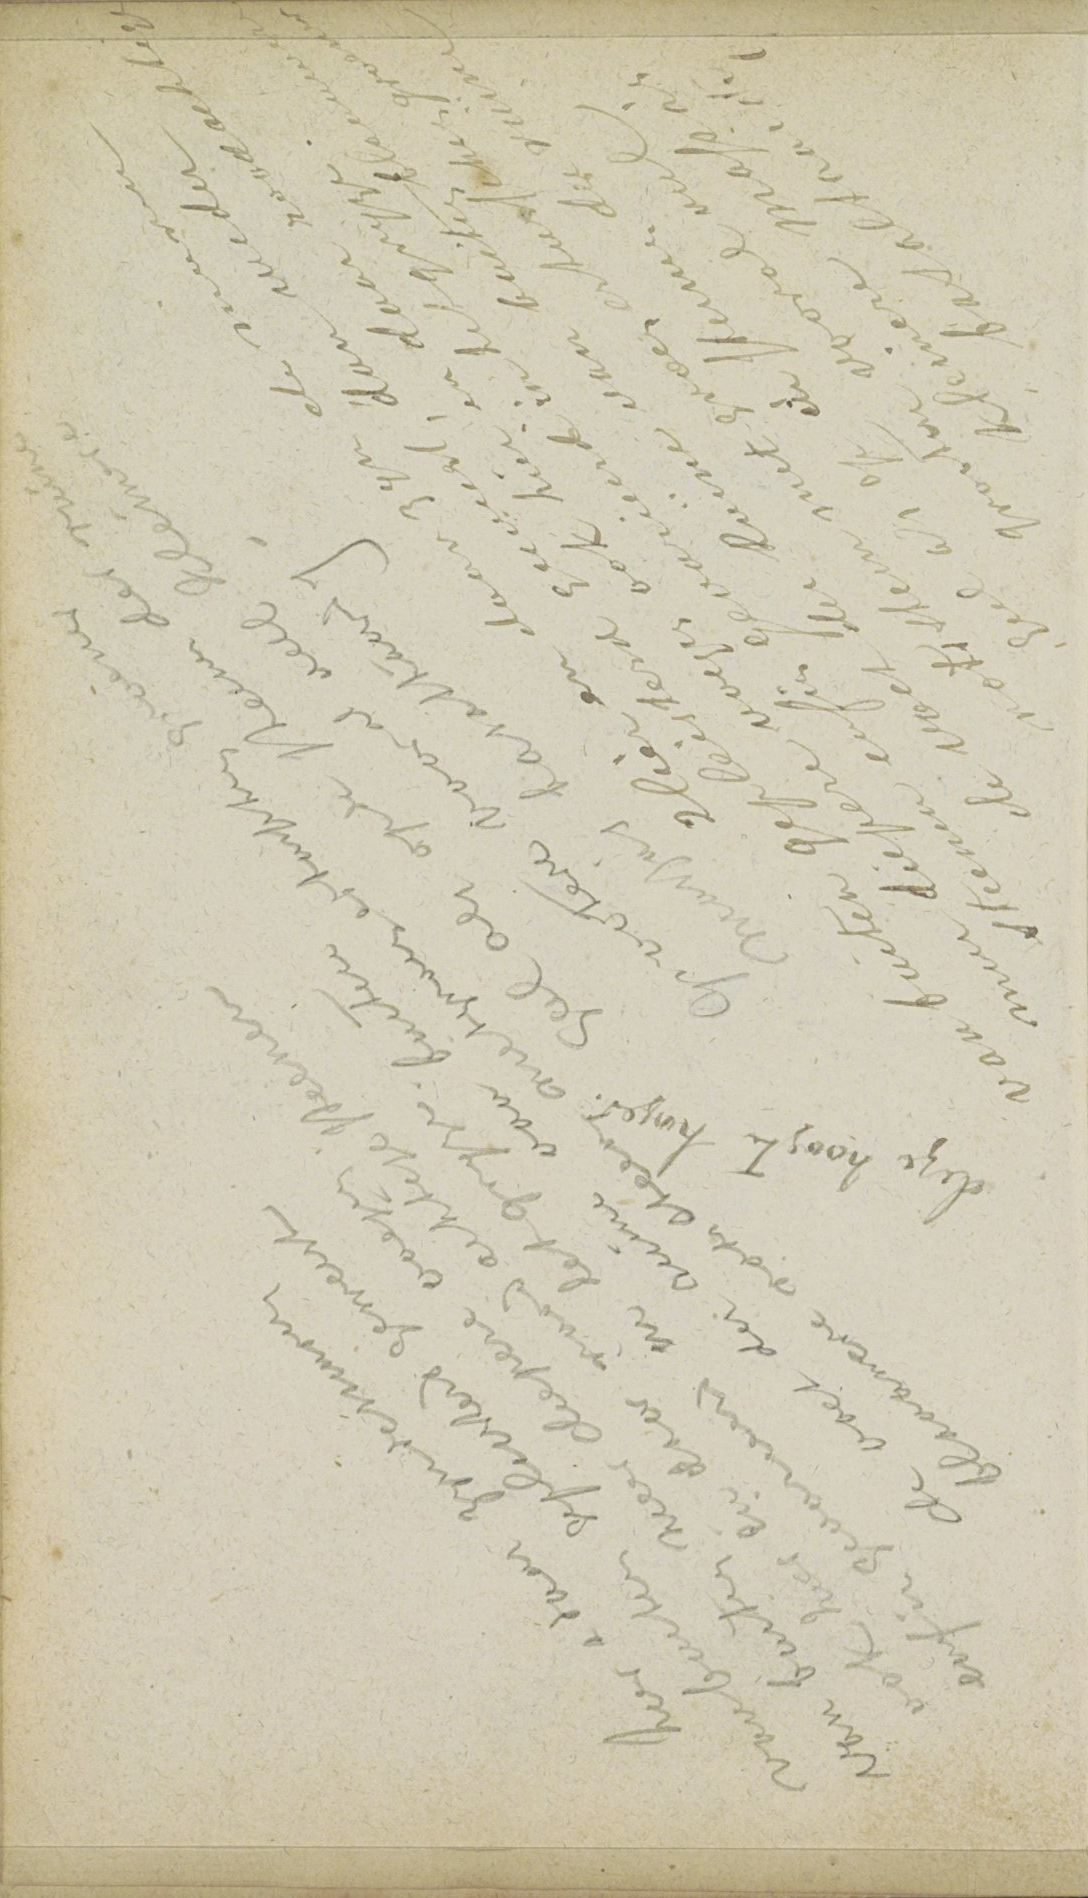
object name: sketchbook leaf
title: Beschrijving van de kasteelruïne op de Desenberg bij Warburg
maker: johannes tavenraat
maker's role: draughtsman, painter, print maker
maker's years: 1809-1881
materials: ink, paper, pencil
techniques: pen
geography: warburg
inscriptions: annotation: ‘[...]’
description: Blad 6 verso uit een schetsboek met 88 bladen.